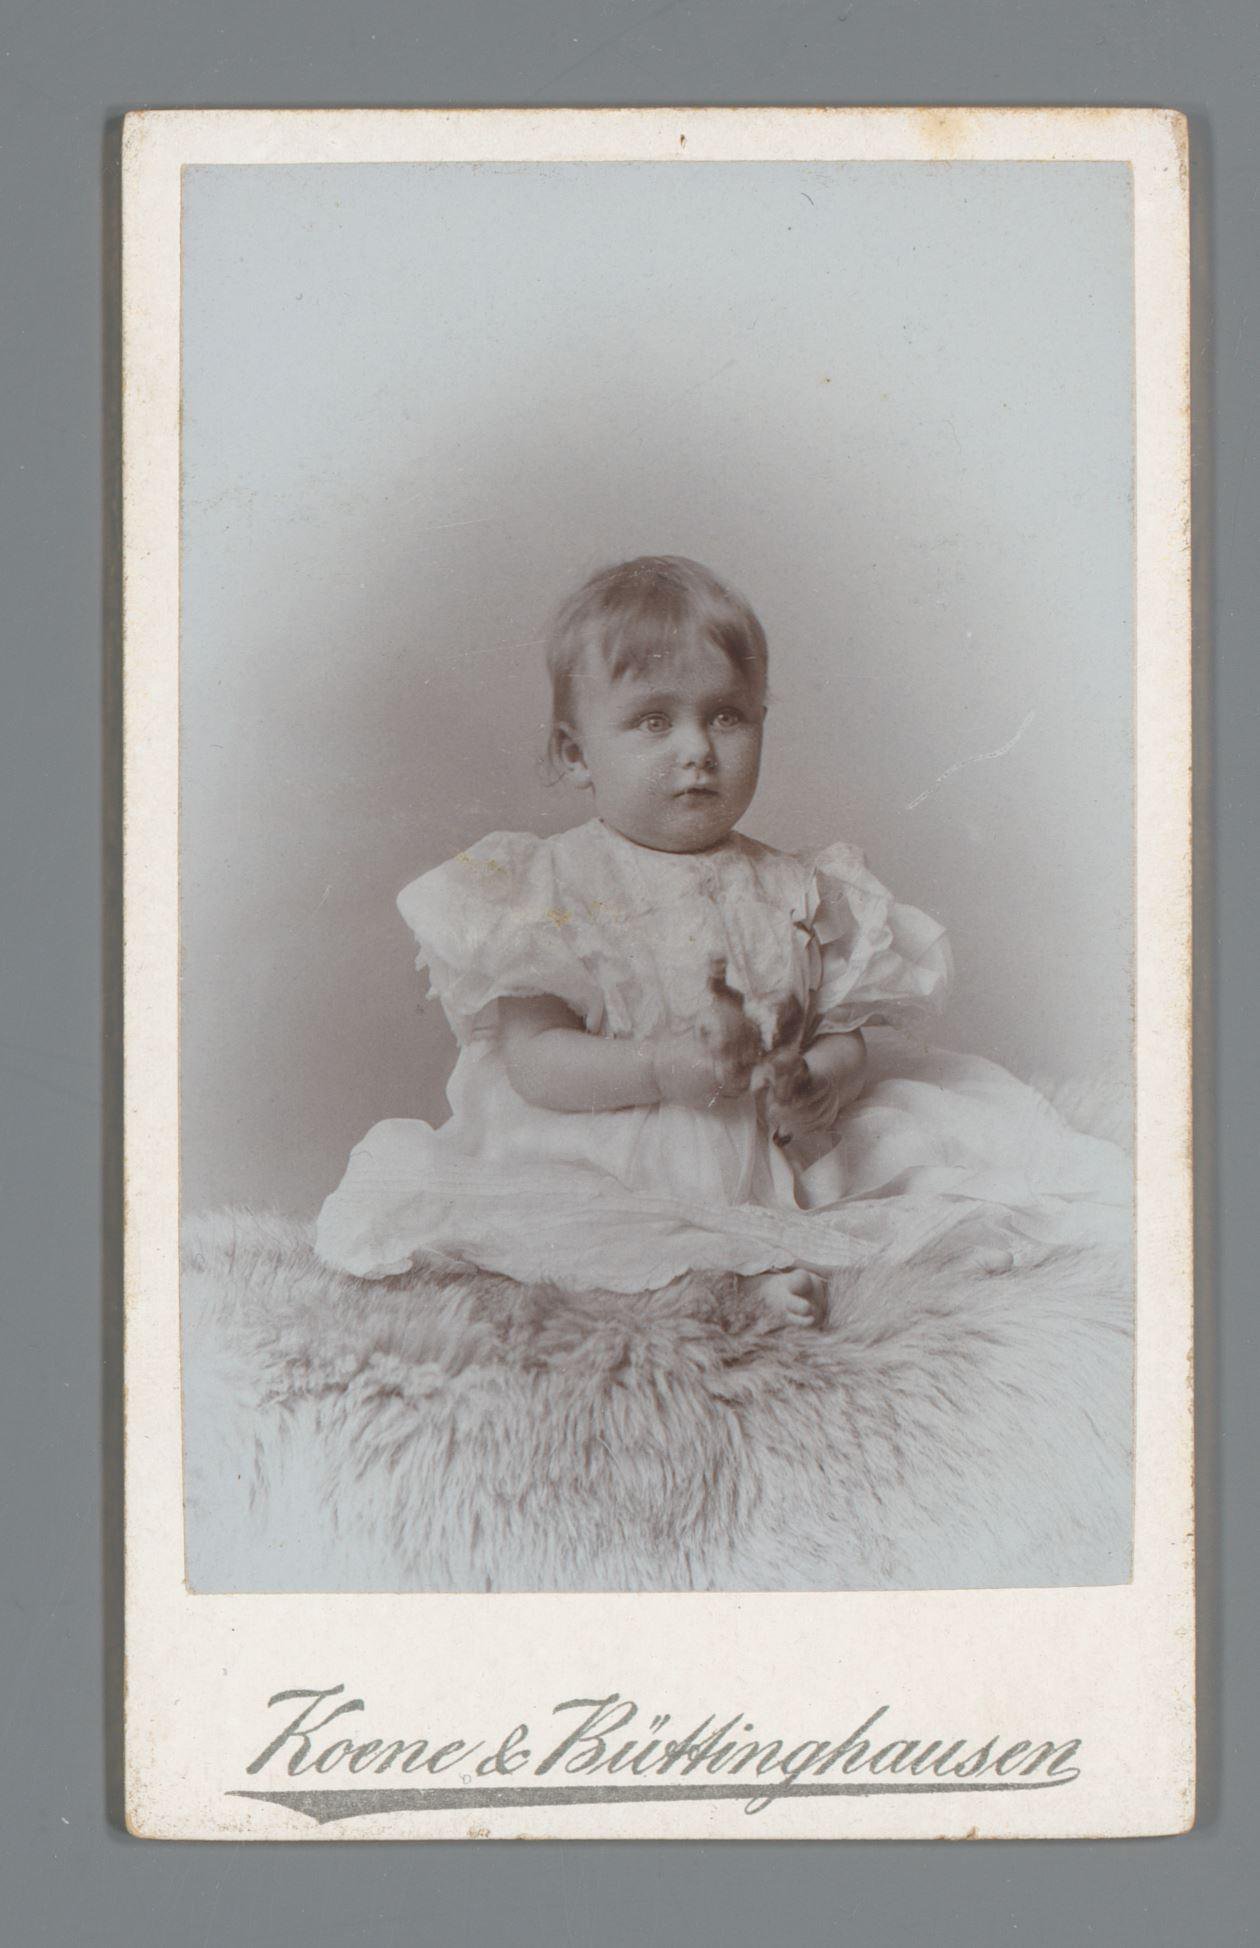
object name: carte de visite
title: Portret van Willem Jonker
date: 1898-1900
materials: cardboard, photographic support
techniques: collodion silver print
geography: amsterdam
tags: historical persons, amsterdam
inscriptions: annotation: ‘Hansje Jonker’, workshop stamp: ‘Koene&Büttinghausen/ Amsterdam Heerengracht 150, Telephoonnummer 1402/ Batavia’